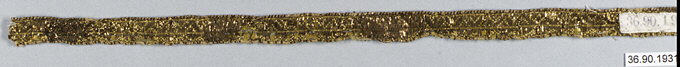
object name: galloon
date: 1601-1700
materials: silk